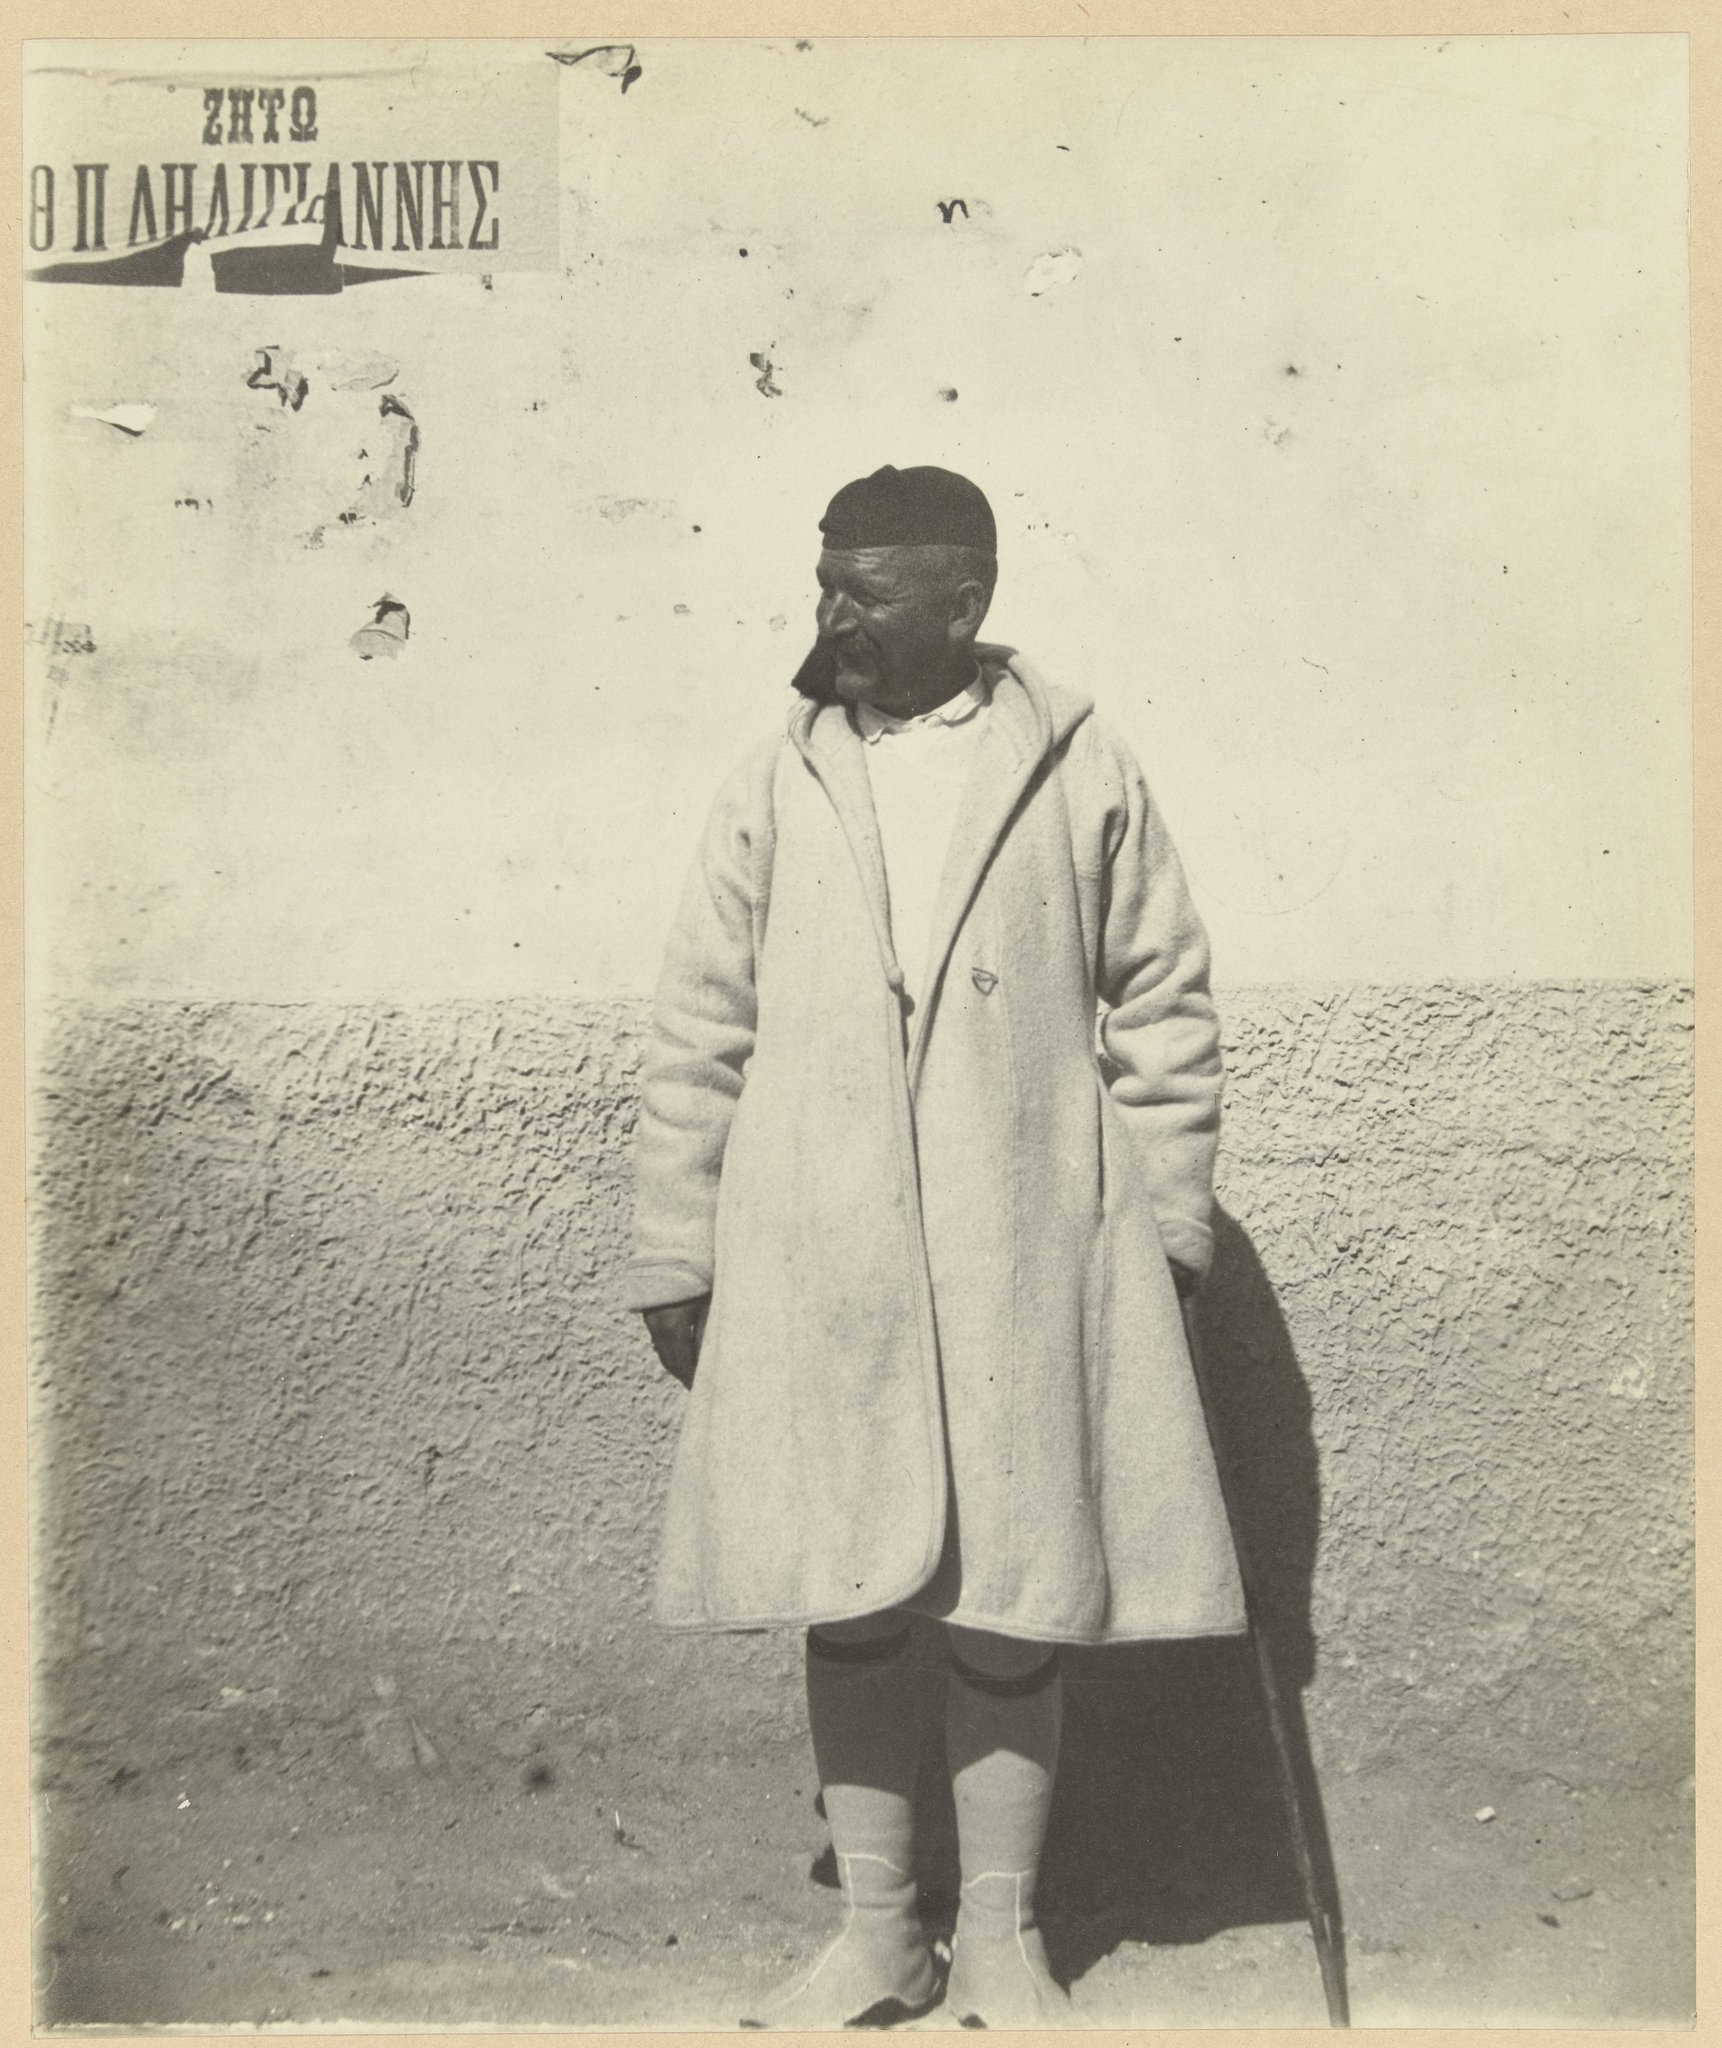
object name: photograph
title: Portret van een onbekende Griekse boer uit Nafplion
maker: mr. l. de bruyn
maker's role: fotograaf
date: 1900-1910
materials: paper, cardboard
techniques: gelatin silver print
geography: nafplion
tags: farmers, coat, cape, historical persons not known by name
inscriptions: inscription: ‘Grieksche landbouwer/ uit Nauplia/ door LdB’, check stamp: ‘Bristol/ L.M.’, stamp: ‘Gemeentelijke bibliotheek/ Rotterdam’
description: Onderdeel van een groep door fotograaf Richard Polak op reis verzamelde foto’s. Deze foto is rond 1910 gemaakt door zijn reisgenoot mr. L. de Bruyn. Foto’s die hij op eerdere reizen verzamelde zijn tentoongesteld bij de Rotterdamsche Kunstkring (1895), Arti en Amicitiae te Amsterdam (1897-1898?) en Societeit 't Collegie te Kampen (datum vooralsnog onbekend).